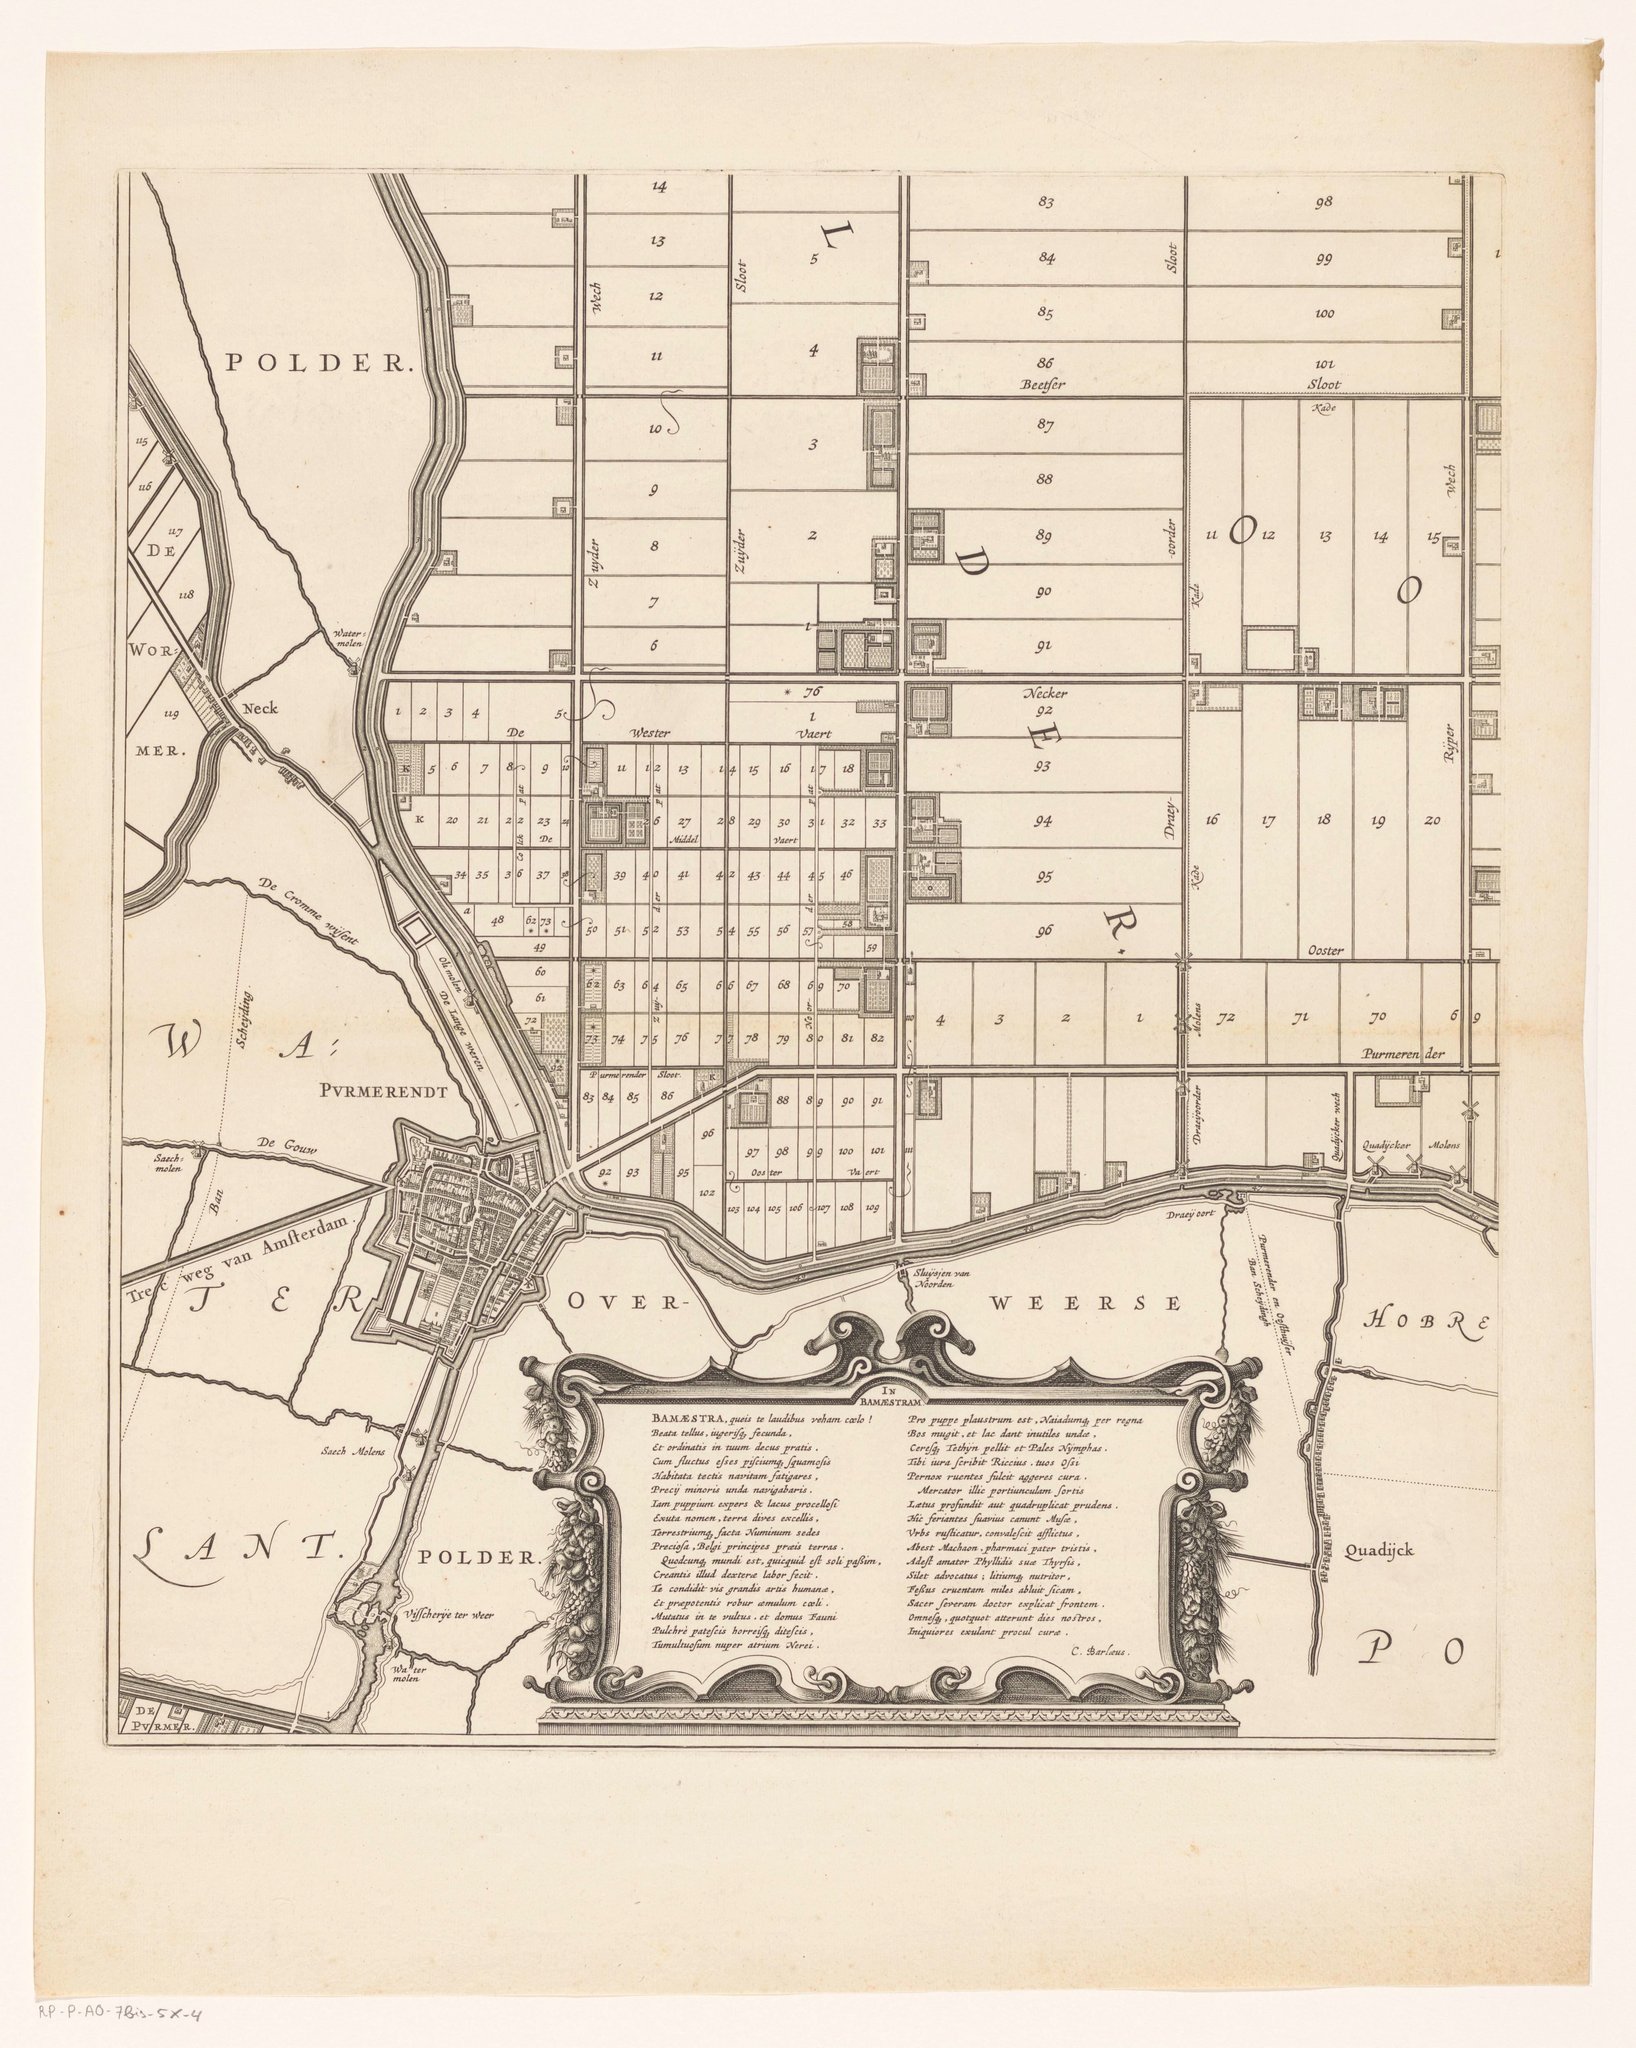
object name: print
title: Beemsterlants caerte met zijne dycken, ringslooten, wegen, wateringe, polders, poldercaden, molens, molentochten, huysen, plantagien. Item omleggende plaetsen, landen en andere eygenschappen, soo als de selve tegenwoordich gheleghen is. Droochgemalen met XL. molens. Gecavelt ende den bedyckers en eygenaers toegeeygendt inden Iare M.DC.XII. op den 30 Iulij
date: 1644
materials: paper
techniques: engraving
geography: amsterdam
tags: maps of separate countries or regions, polder, reclaimed land, beemster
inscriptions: collector's mark: Lugt 19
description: Deel (linksonder) van een kaart van de Beemster.